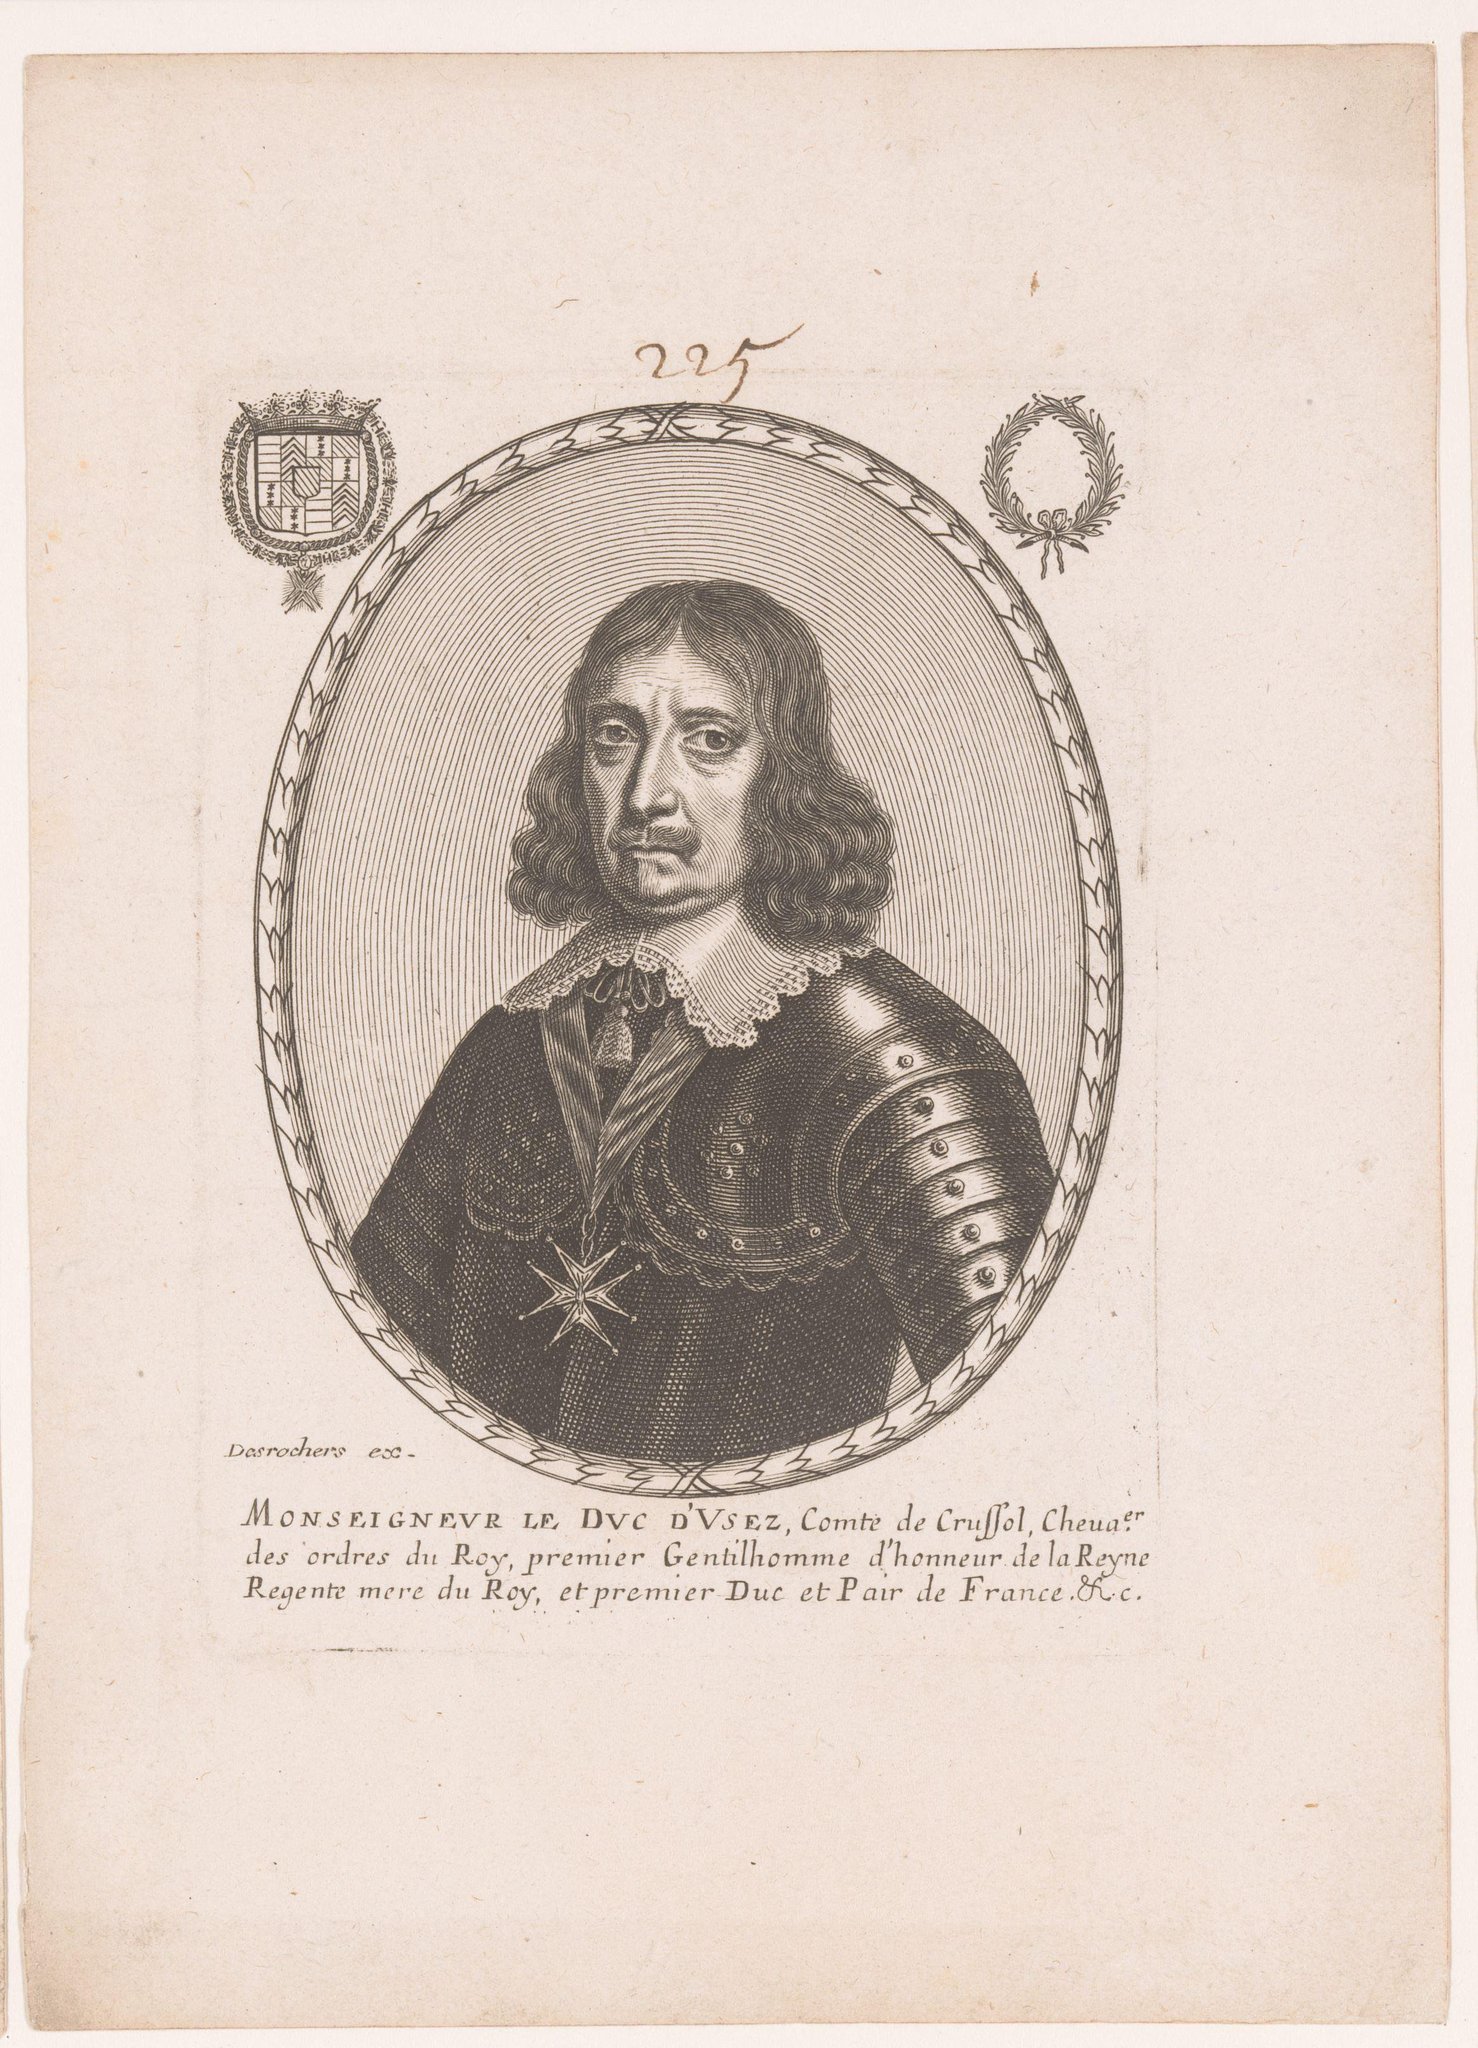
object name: print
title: Portret van François de Crussol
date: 1654-1668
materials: paper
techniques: engraving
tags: historical persons, armorial bearing, heraldry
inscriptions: number: ‘225’, collector's mark: Lugt 2228